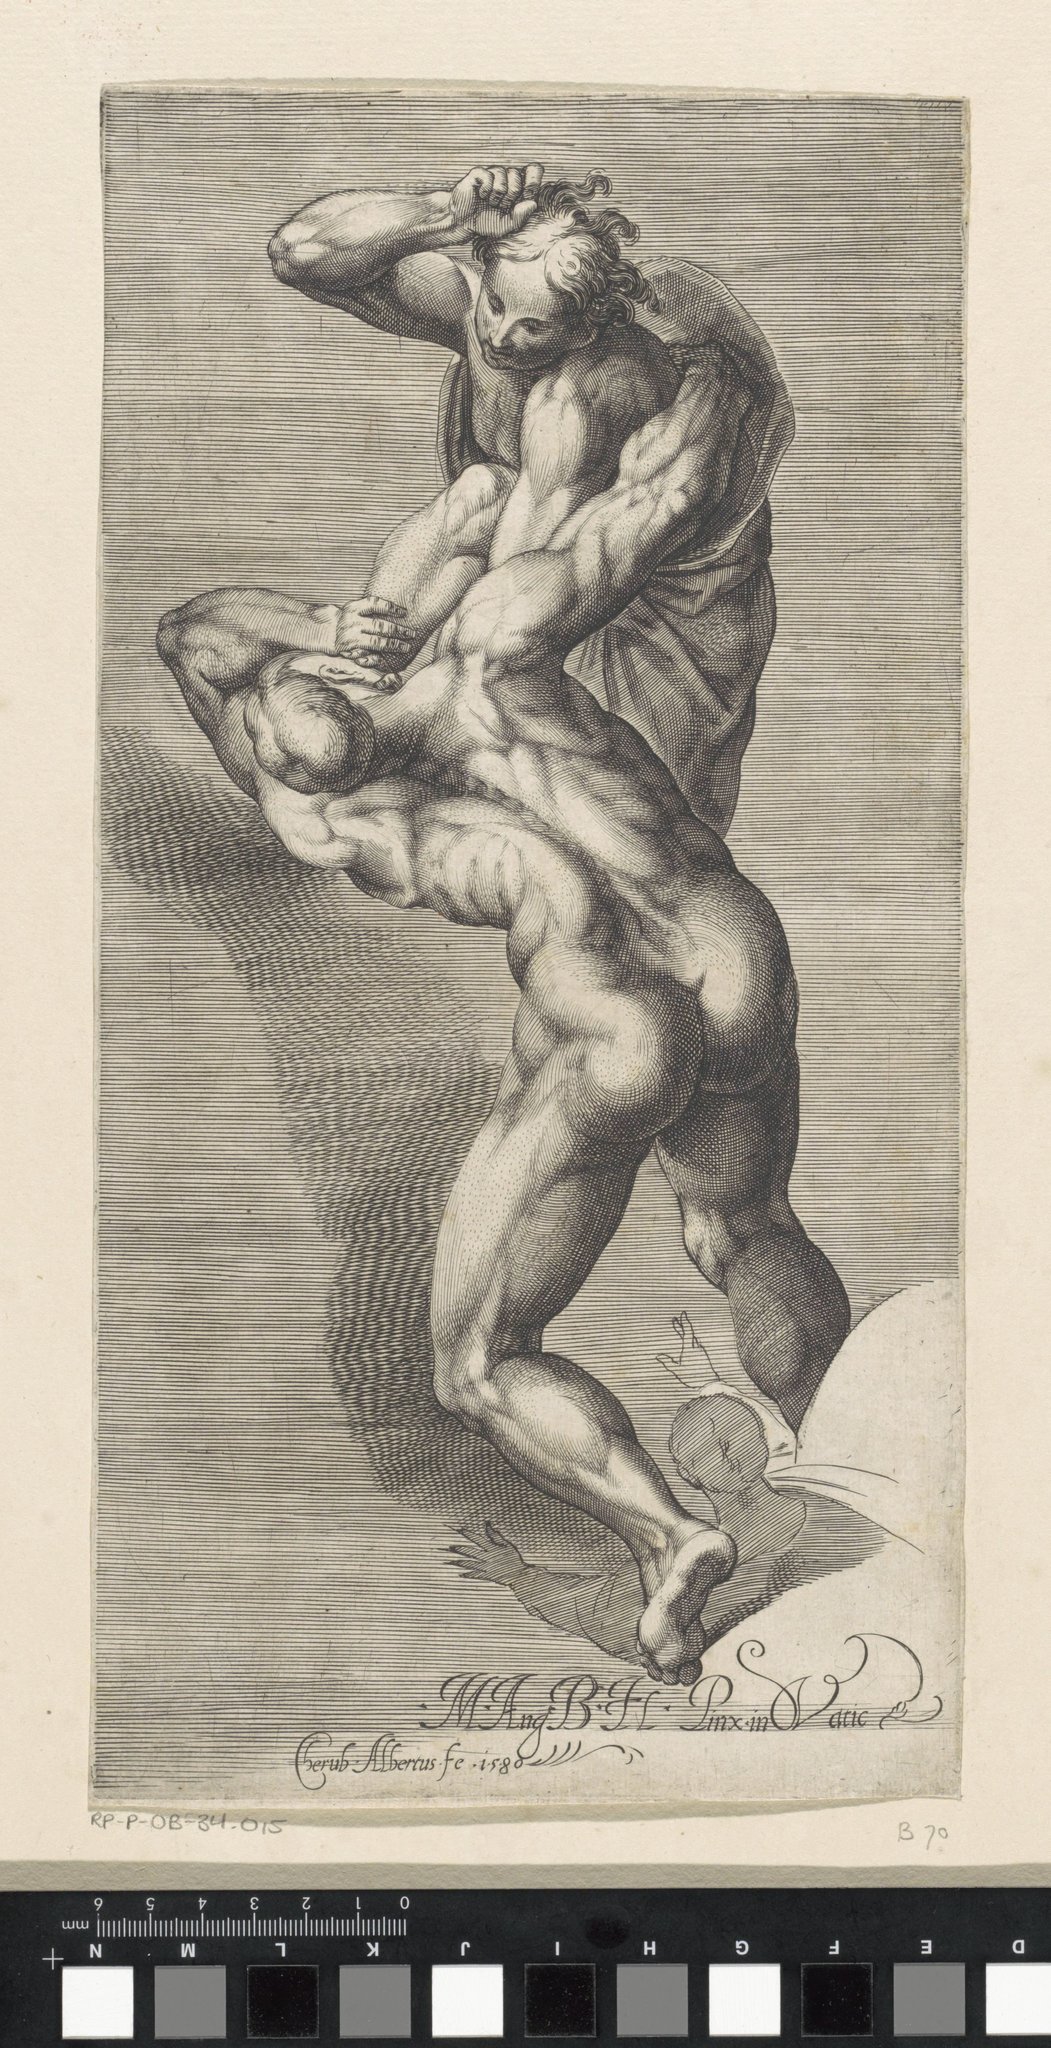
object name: print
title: Verdoemde zielen in gevecht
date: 1580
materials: paper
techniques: engraving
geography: vatican city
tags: the damned souls, and their punishment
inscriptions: date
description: Prent uit een reeks van vijf prenten met figuren uit het 'Laatste Oordeel' van Michelangelo in de Sixtijnse Kapel (Bartsch 67-71).